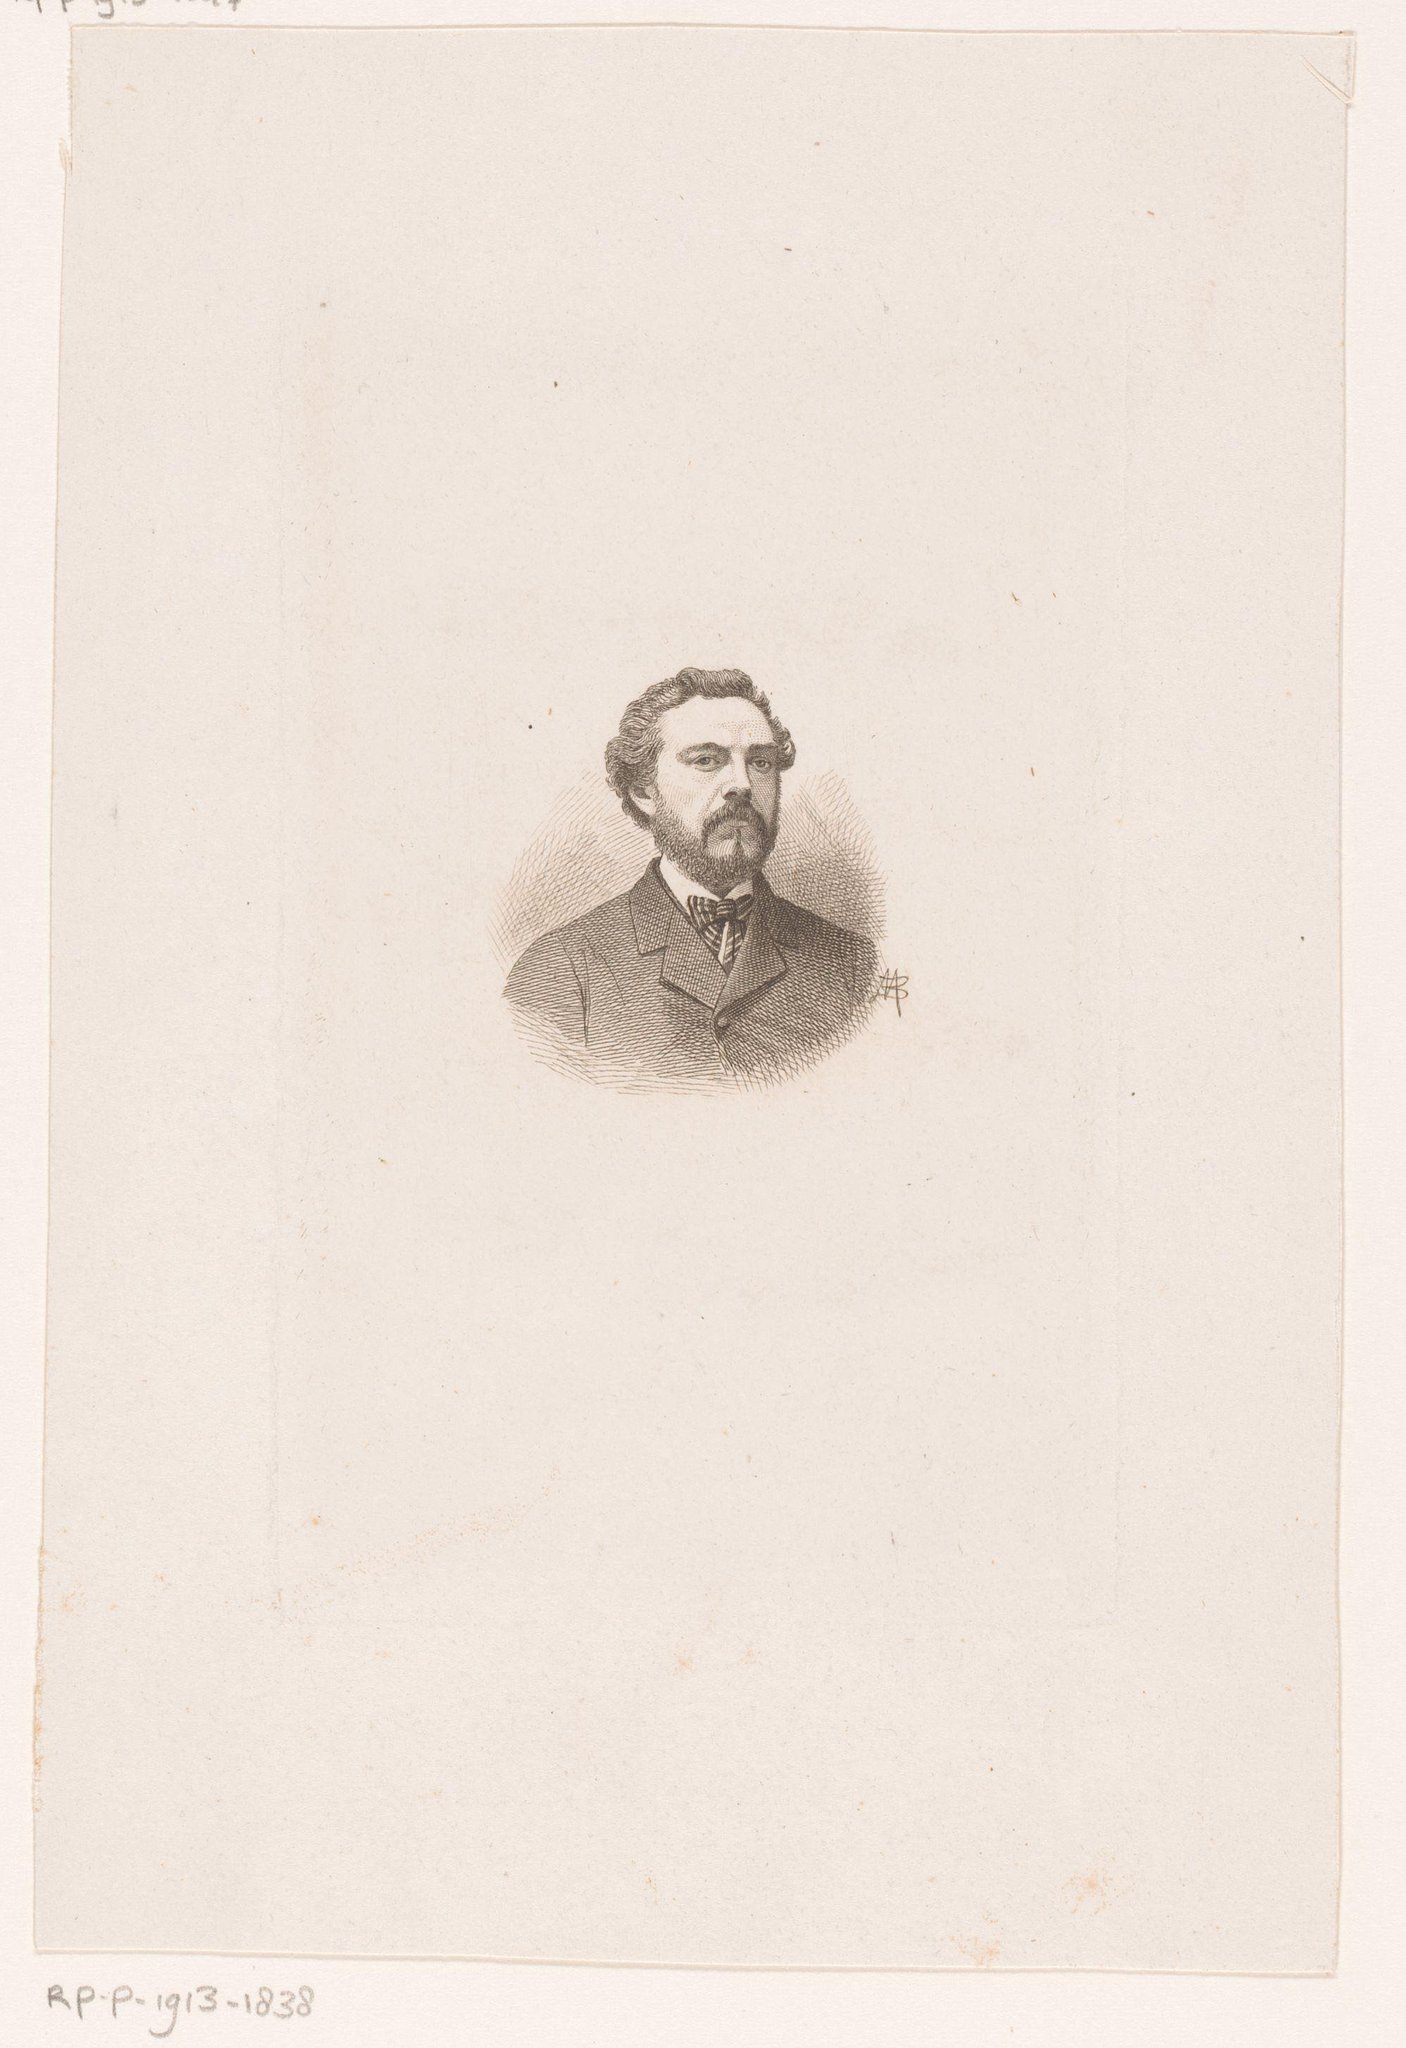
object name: print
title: Portret van Frans de Cort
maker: jean baptiste pierre michiels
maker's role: print maker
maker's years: 1821-1890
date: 1831-1890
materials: paper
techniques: etching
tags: adult man, historical persons, writer, poet, author, beard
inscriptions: collector's mark: Lugt 2228